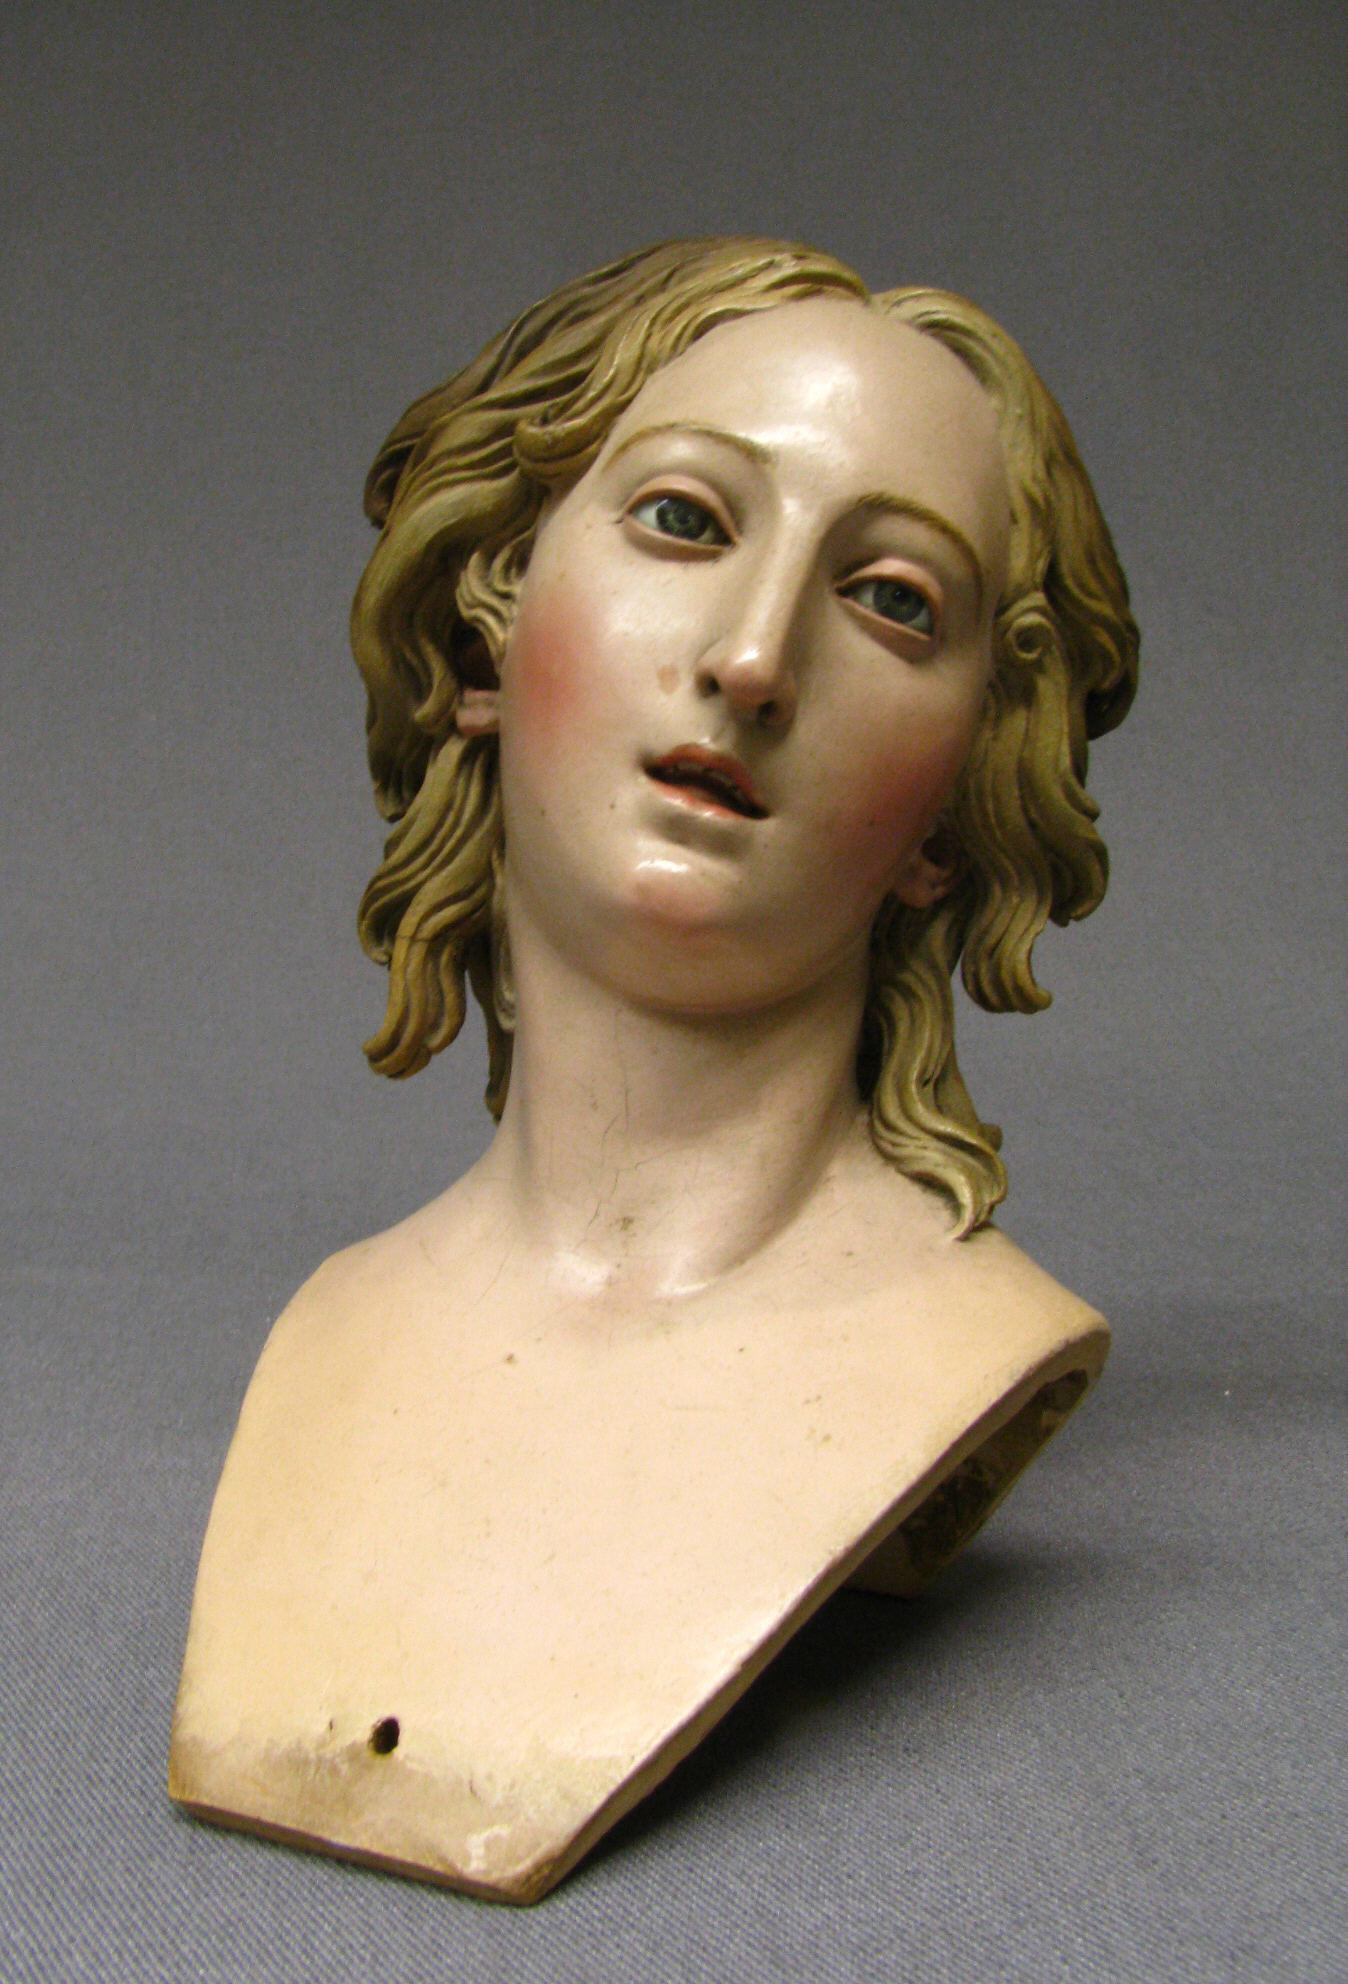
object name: crèche figure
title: Bust (probably of an angel)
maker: giuseppe gori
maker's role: maker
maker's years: 1770-1810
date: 1767-1833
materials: glass, terracotta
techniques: polychrome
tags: faces,women